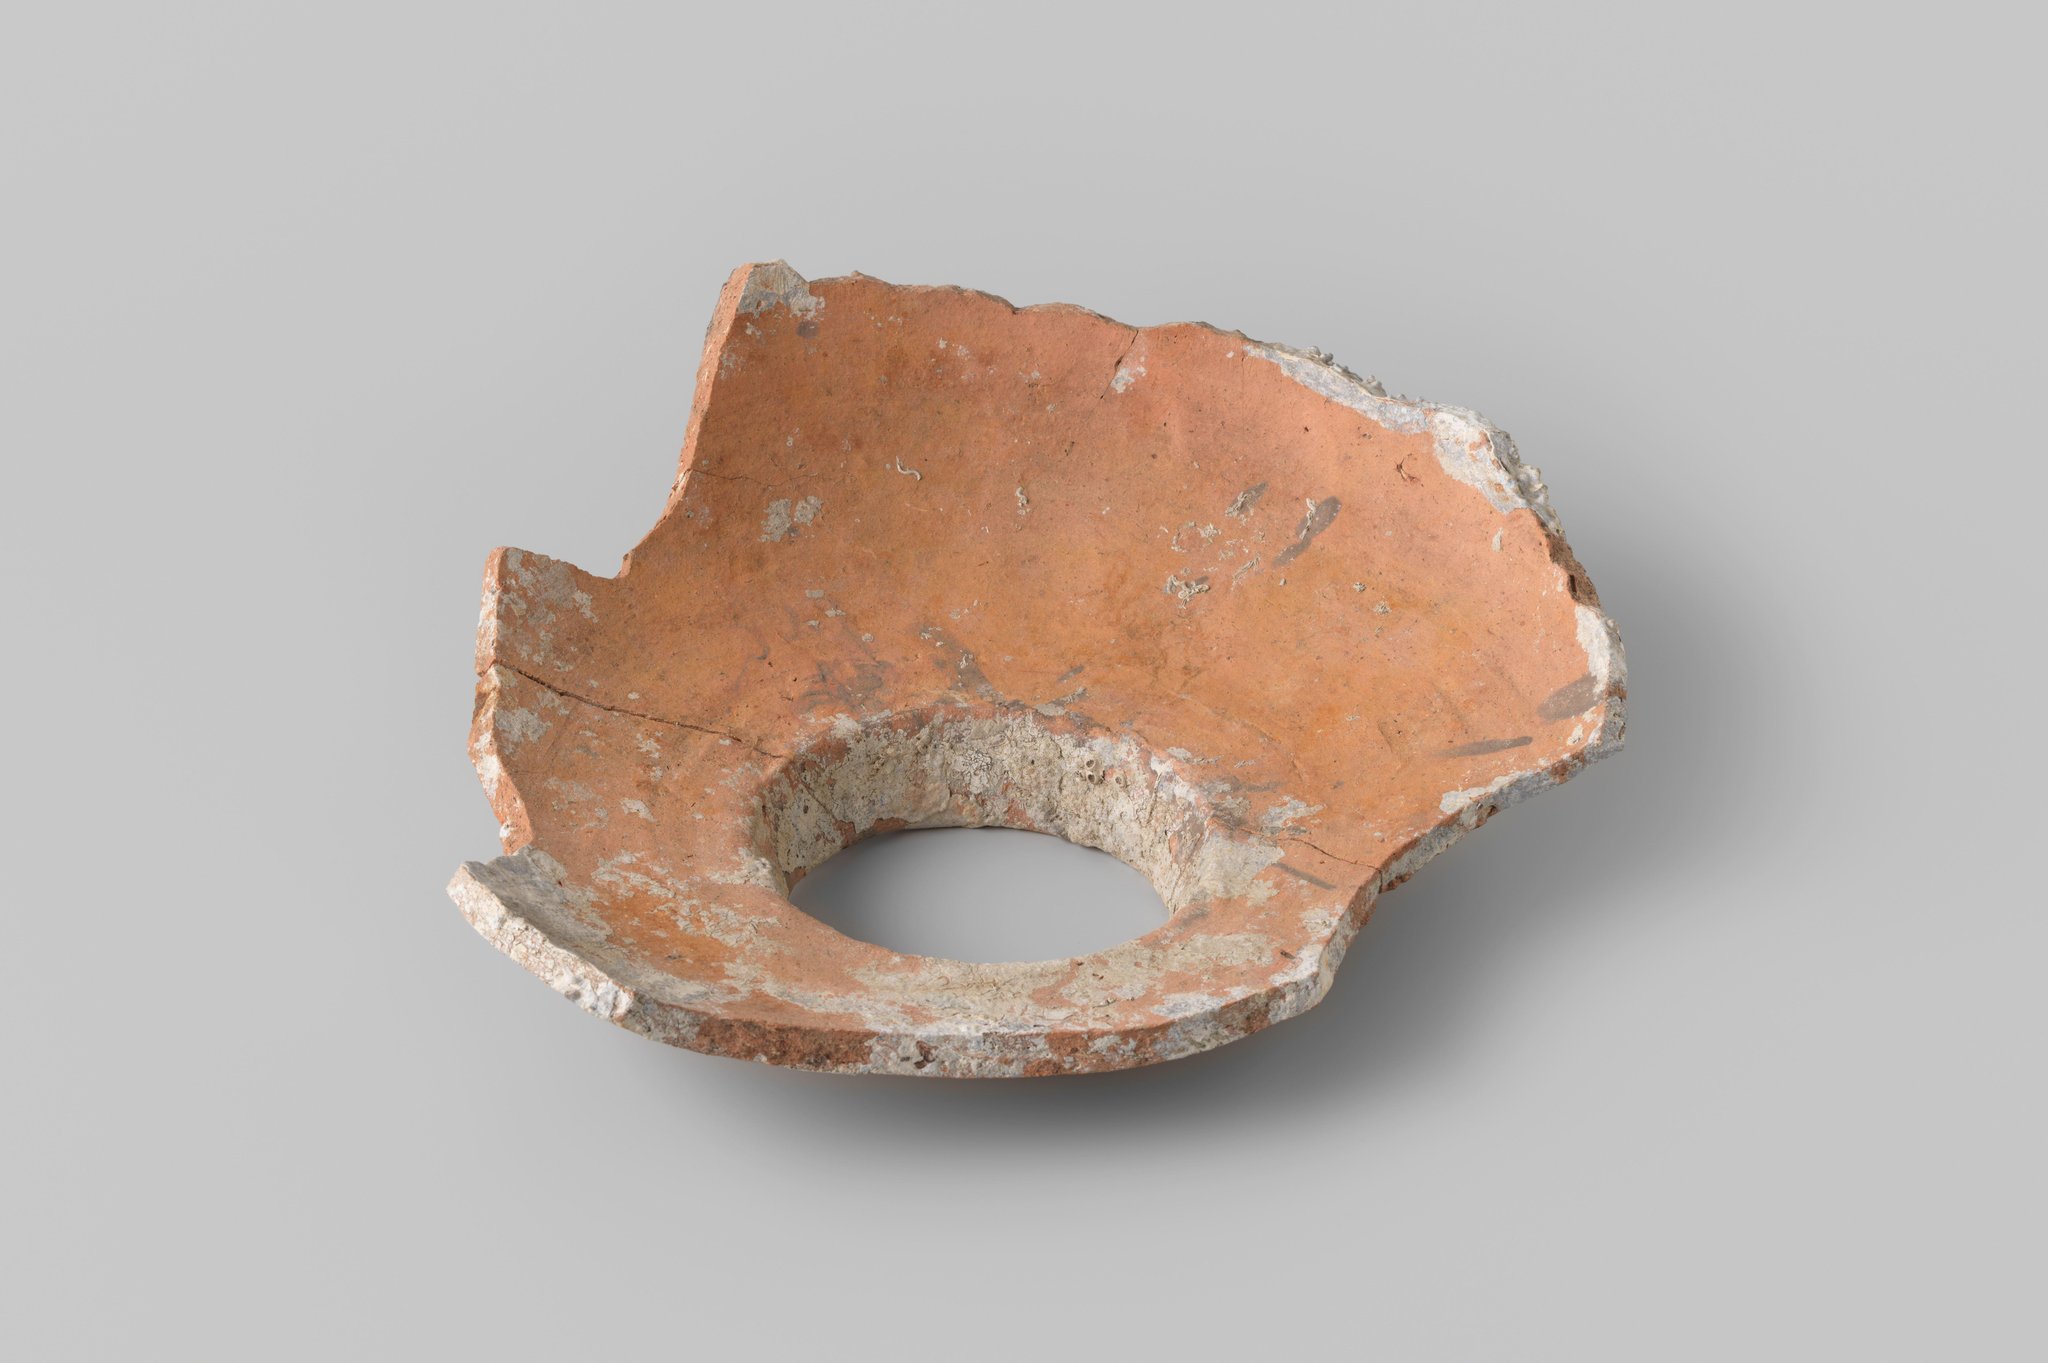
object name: vessel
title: Fragment martavaan uit V.O.C.-schip de 'Witte Leeuw'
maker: Anonymous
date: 1613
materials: porcelain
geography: southeast asia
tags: verenigde oostindische compagnie, sint-helena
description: A jar. The ovoid shaped body has a short neck with an everted, rolled lip. There are four standing decorated ears which are connected by a ridge. The stoneware body is coloured grey and red and has black discolourations. The exterior and lip rim is covered with a yellow brown glaze. On the inside of the neck and junction of shoulder are traces of this glaze.